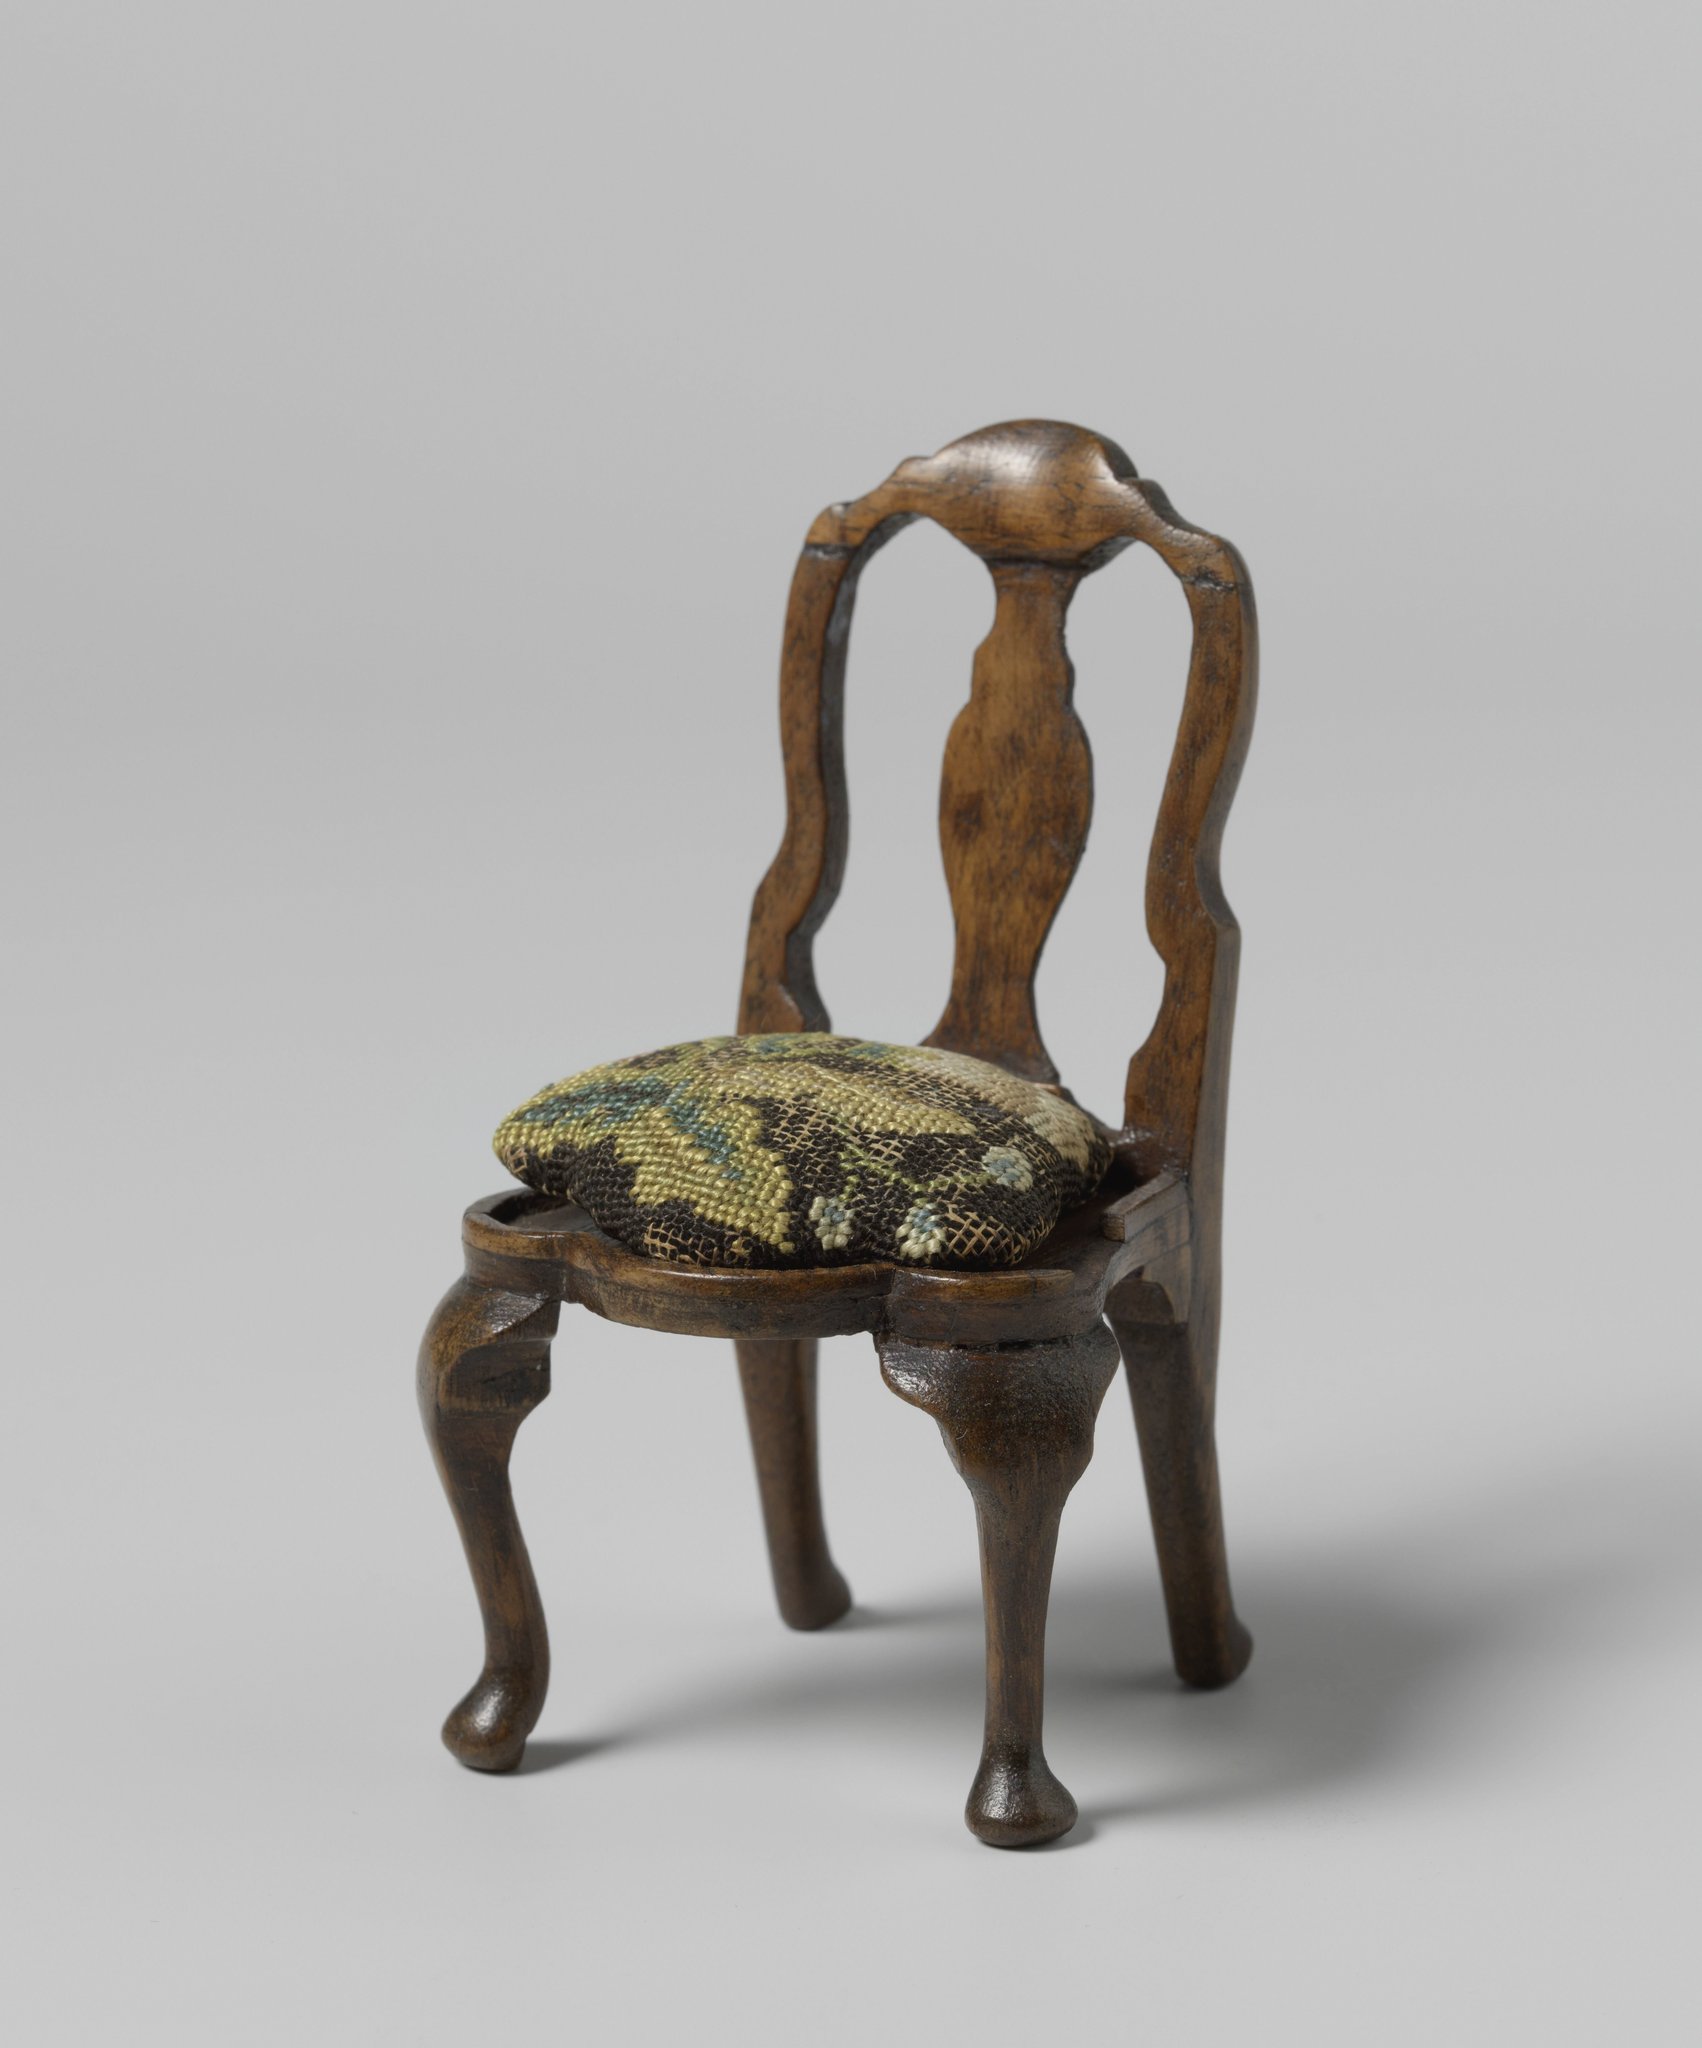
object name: miniature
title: Stoel, behorend tot een elfdelig ameublement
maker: Anonymous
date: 1750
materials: silk, wood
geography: amsterdam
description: Stoel, vervaardigd van notenhout, behorend tot een elfdelig ameublement, bestaande uit een bank en tien stoelen. De zitting van buurduurwerk met blad- en bloemmotieven in zijde op linnen stramien, met een zachte vulling.